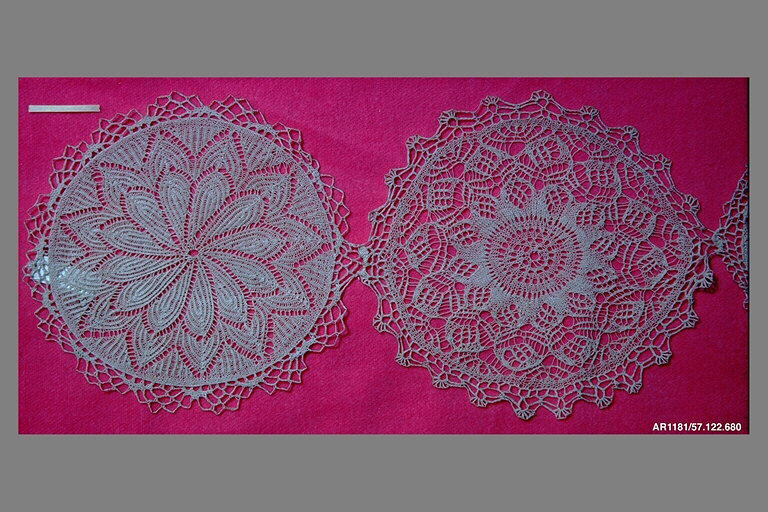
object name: sampler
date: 1801-1900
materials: cotton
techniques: crochet